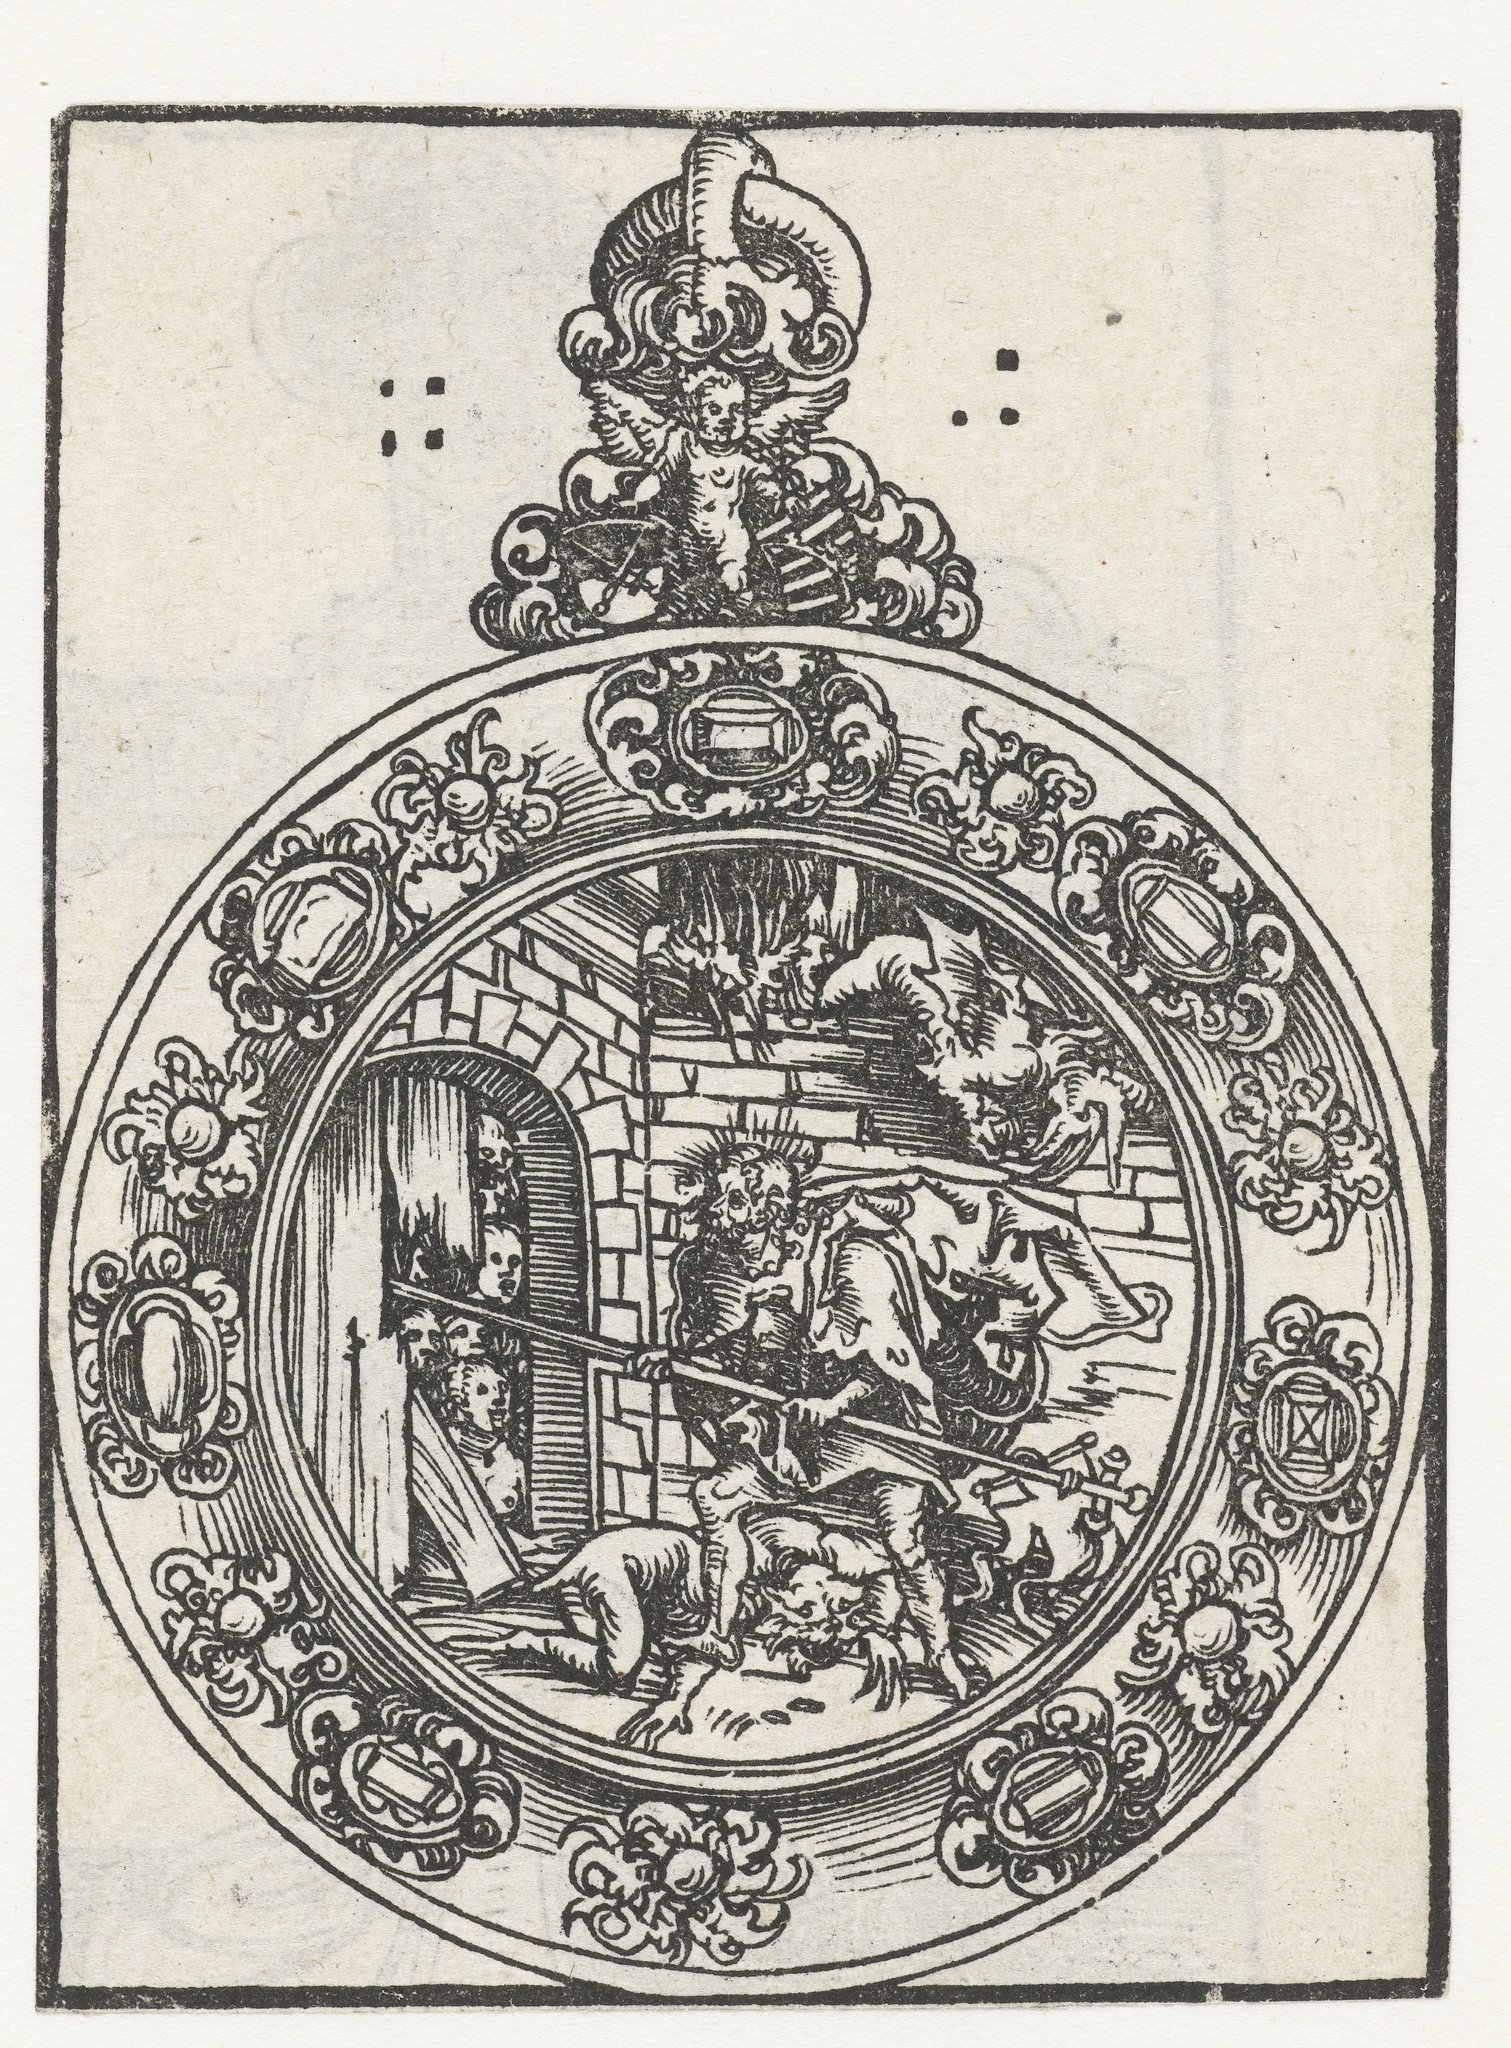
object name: print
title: Reliekhouder in vorm van medaillon met Christus in hel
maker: lucas cranach (i)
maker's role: draughtsman, print maker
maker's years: 1472-1553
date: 1509-1549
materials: paper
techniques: woodcut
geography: wittenberg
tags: christ arrives at the entrance of hell and breaks the door(s)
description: De houtblokken werden in 1509 voor het eerst gebruikt in: Dye zaigung des hochlobwirdigen hailigthums der Stiftkirchen allerhailigen zu wittenburg, Wittenberg, Symphorian Reinhart. Daarna volgden verschillende uitgaven van de Hortulus Animae (uitgever Georg Rhau) waarin de blokken opnieuw gebruikt werden.